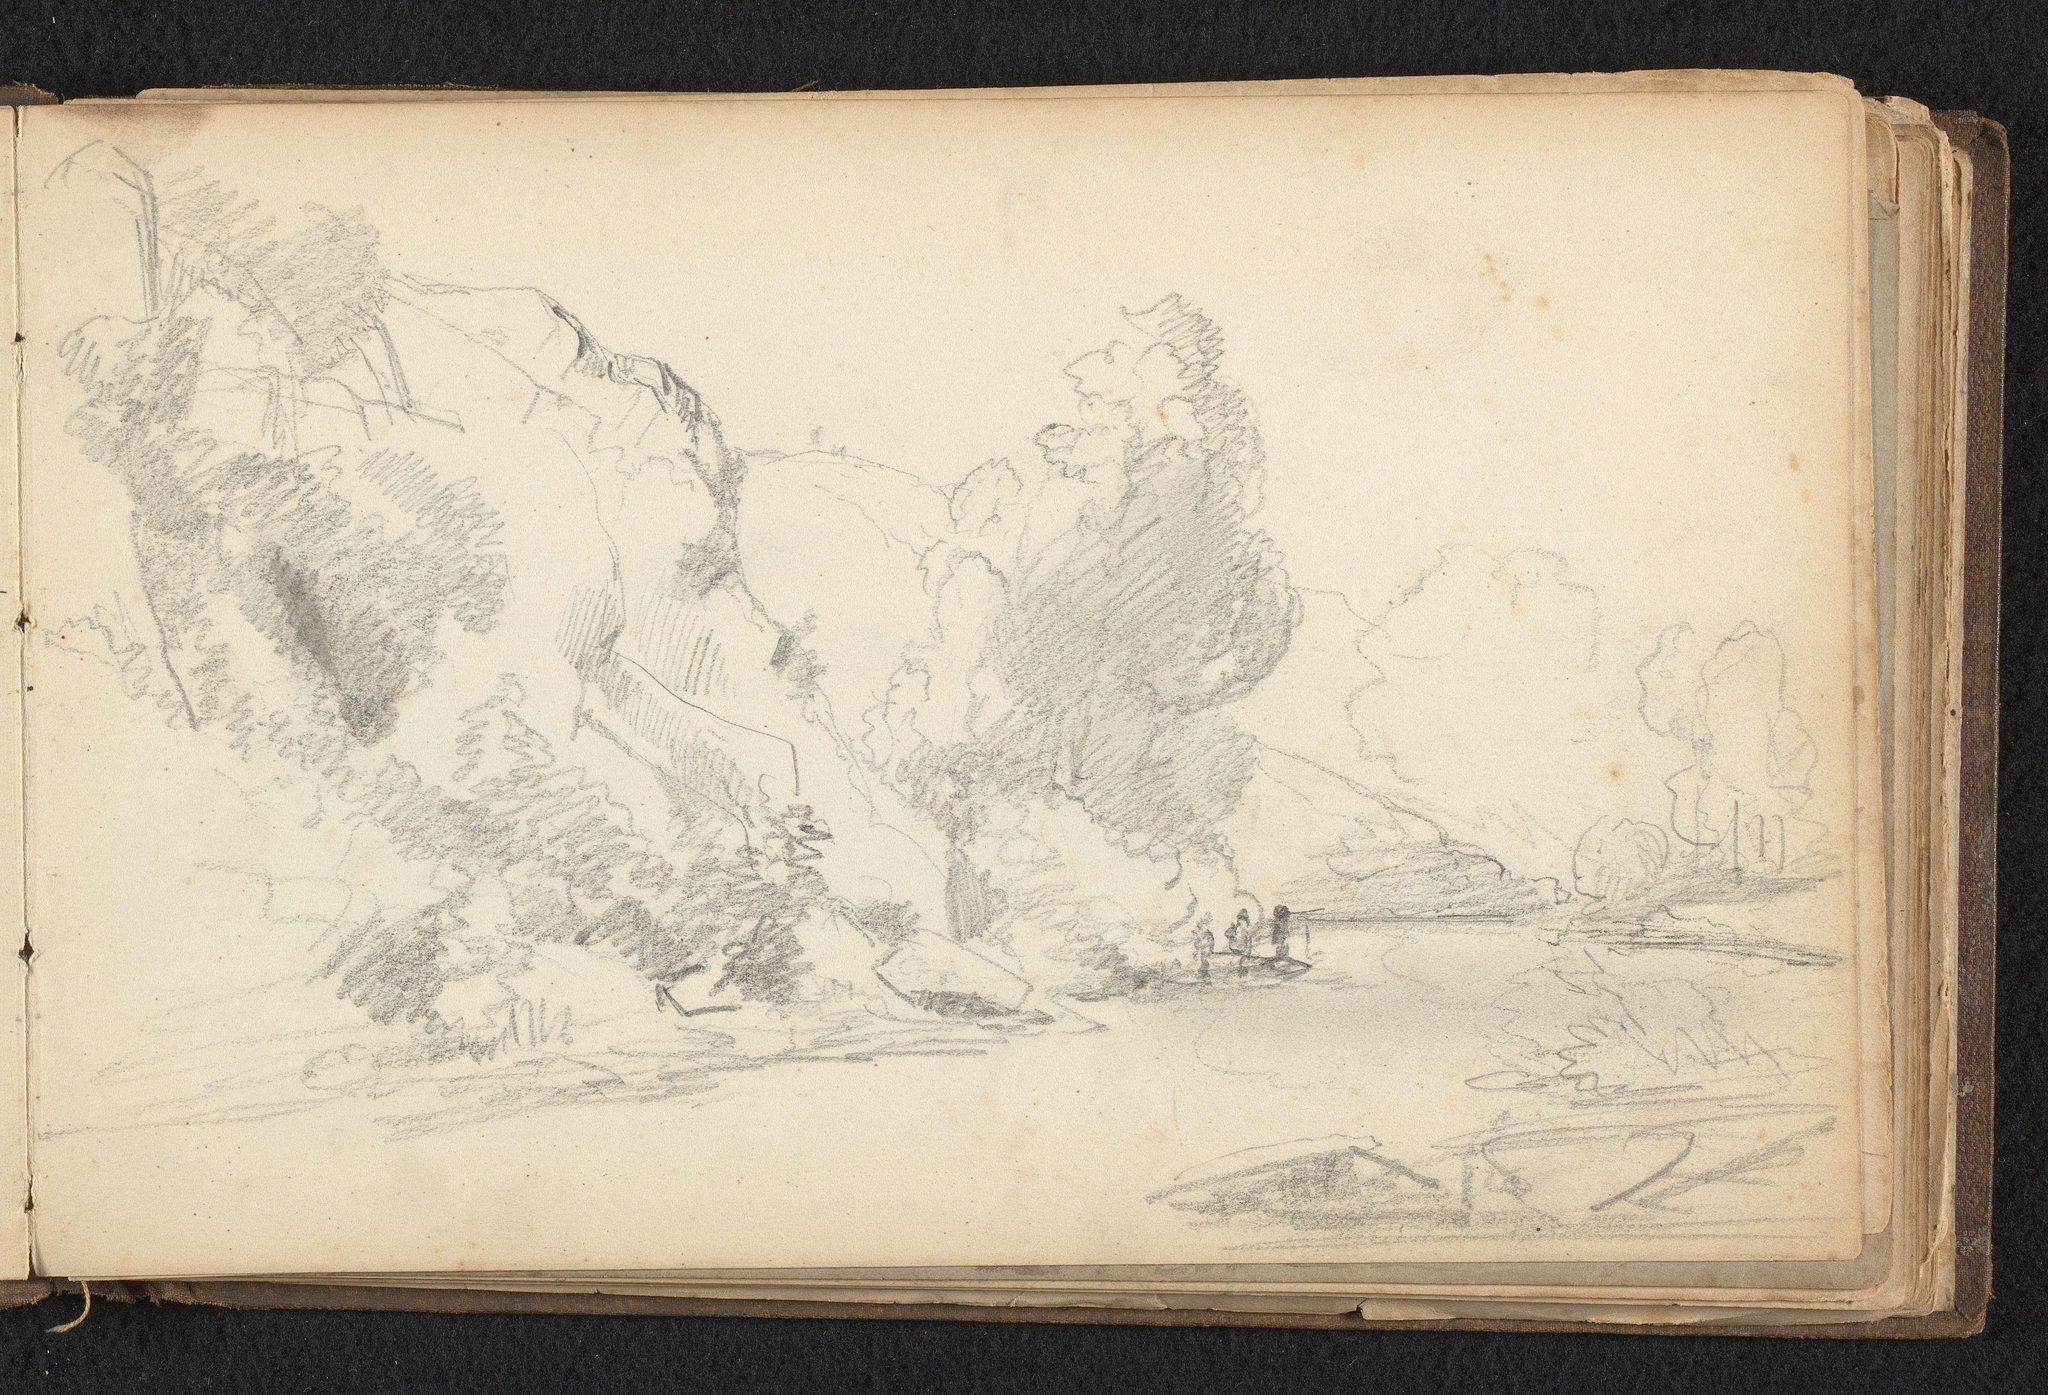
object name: sketchbook leaf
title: Heuvelig landschap met rivier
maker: jan bedijs tom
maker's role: draughtsman, painter, print maker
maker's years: 1813-1894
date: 1823-1894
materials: paper, pencil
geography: the hague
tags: low hill country, river, river bank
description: Pagina 34 verso uit een schetsboek met 37 bladen.